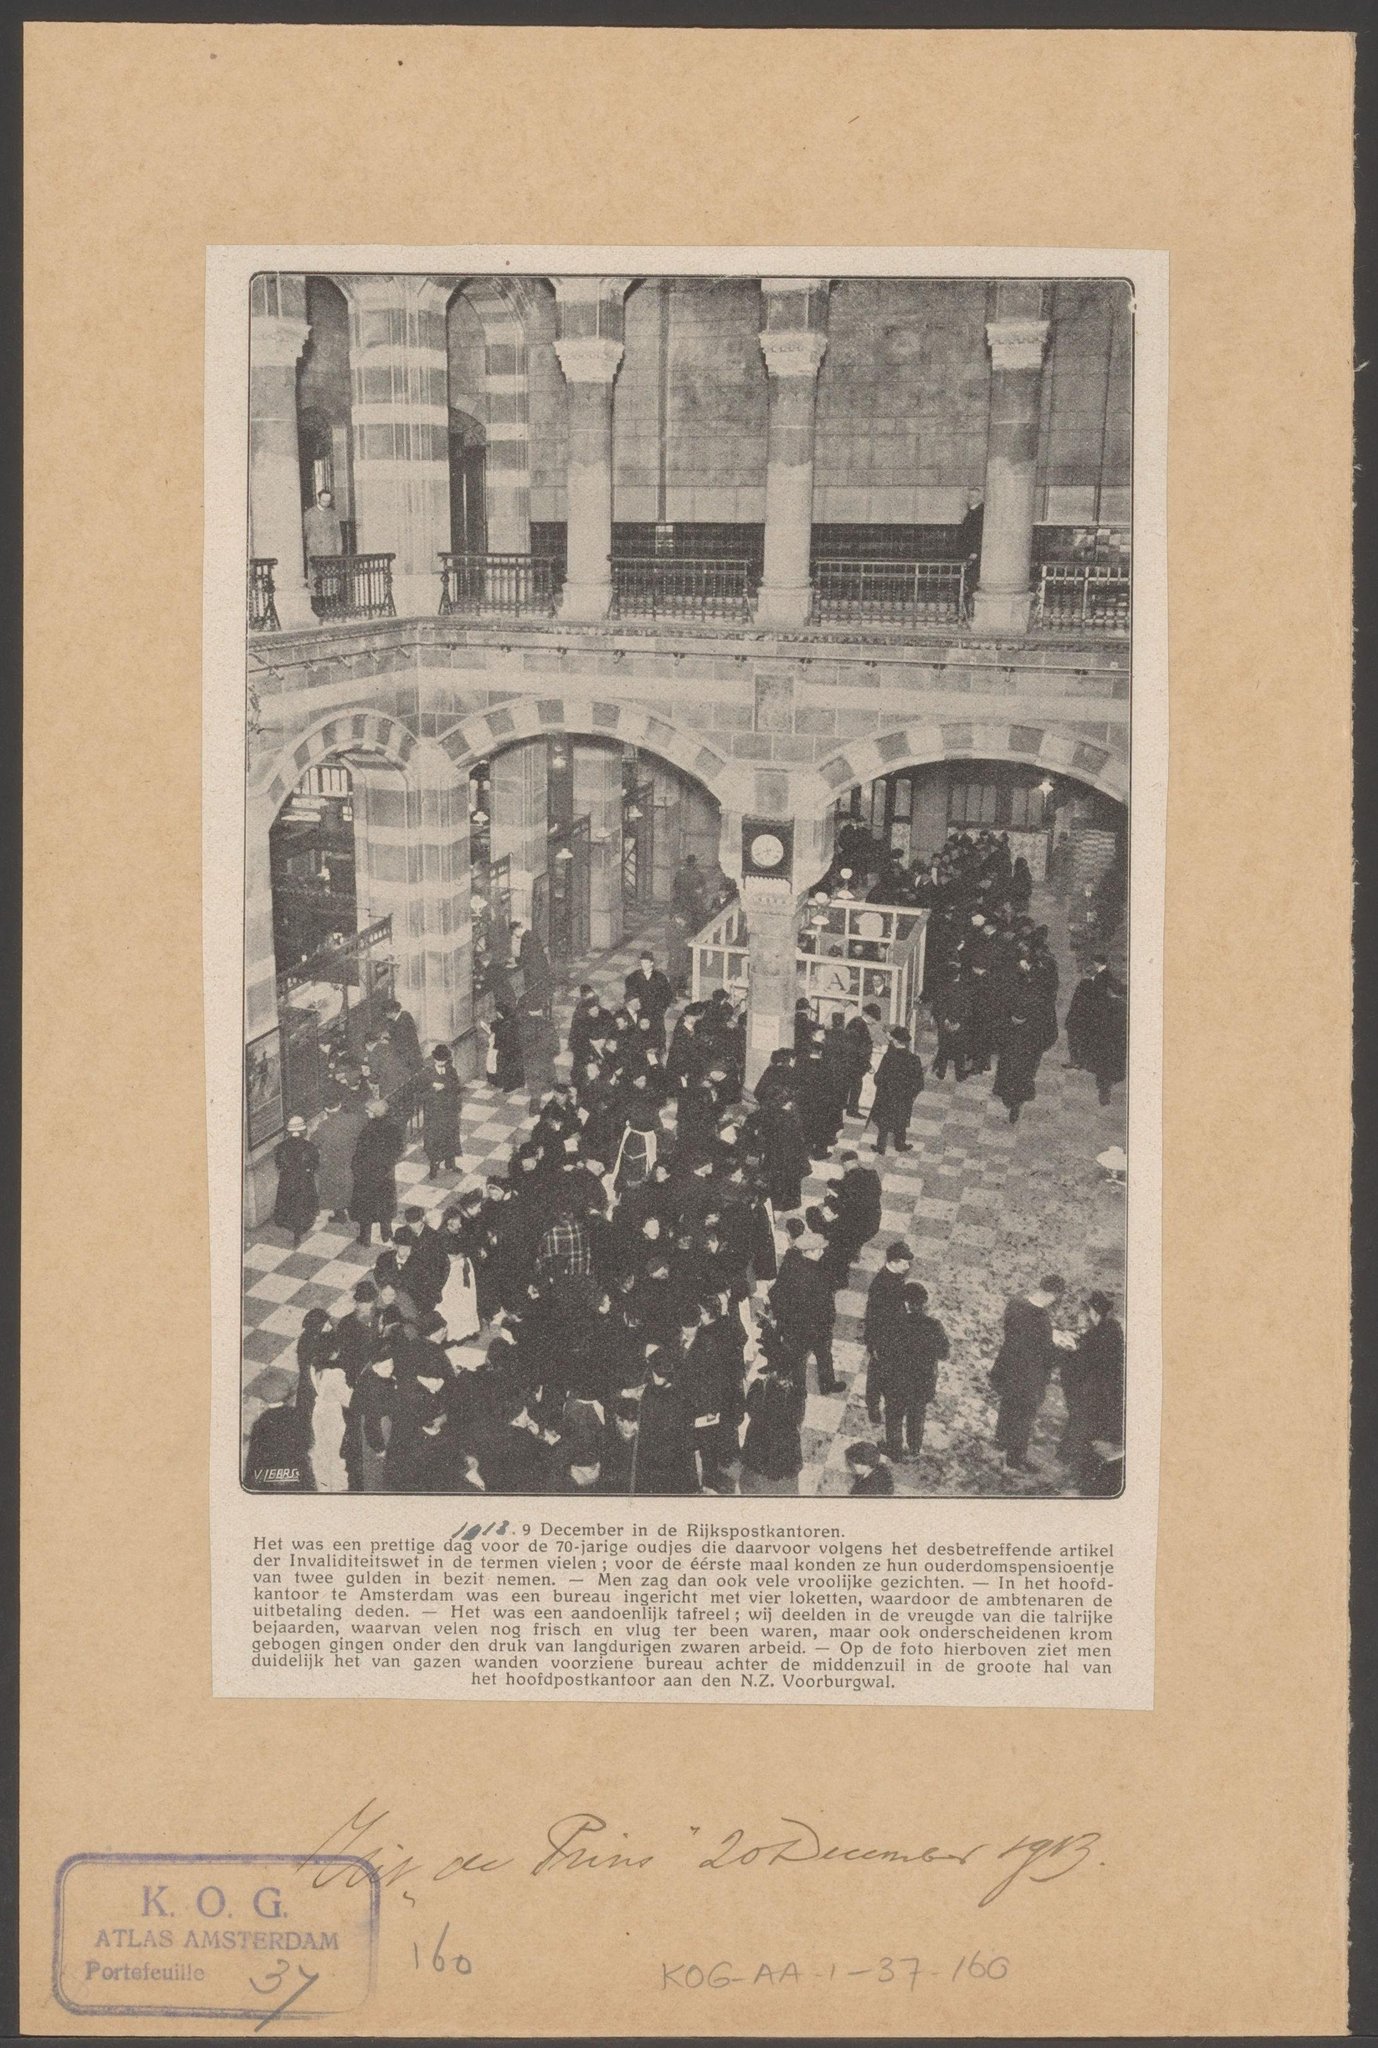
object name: photomechanical print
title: 9 December in de Rijkspostkantoren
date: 1913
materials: paper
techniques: letterpress printing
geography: amsterdam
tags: public welfare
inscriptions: collector's mark: Lugt 1641b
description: Onderwerpsrubriek binnen de Atlas Amsterdam: Armwezen en liefdadige instellingen: I. Stadsinrichtingen: Ouderdomspensioen.